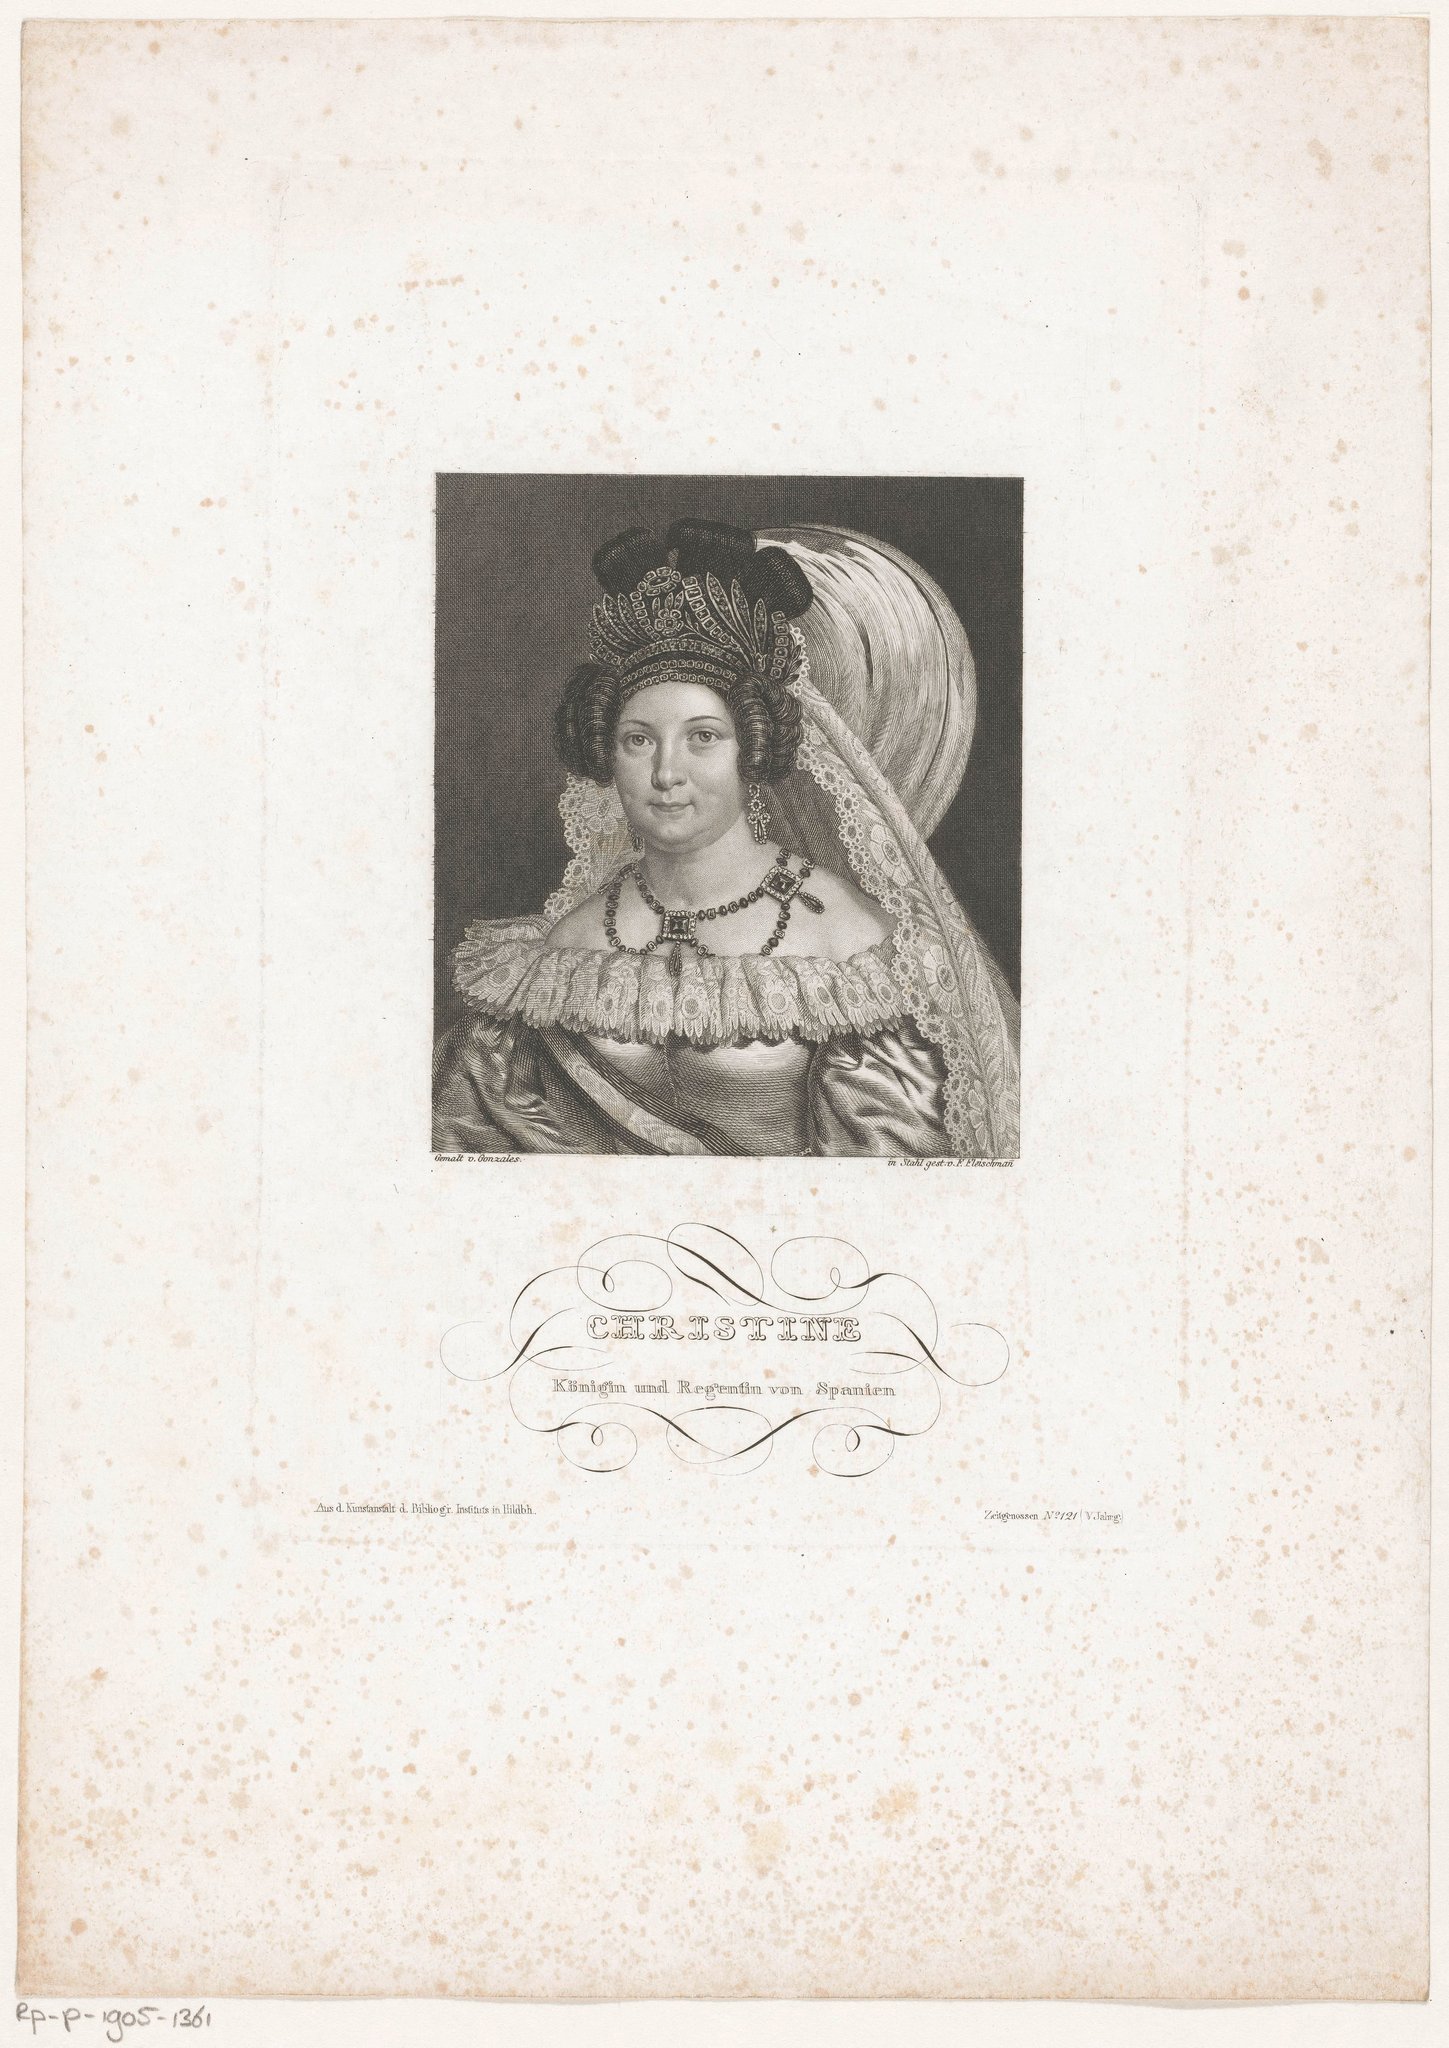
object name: print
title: Tijdgenoten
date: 1829-1834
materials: paper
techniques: engraving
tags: le havre, historical persons - bb - woman, ruler, sovereign - bb - female ruler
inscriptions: collector's mark: Lugt 2228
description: Afkomstig uit de portretserie 'Zeitgenossen', uitgegeven tussen 1829 en circa 1840. No. 121, jaargang 5.